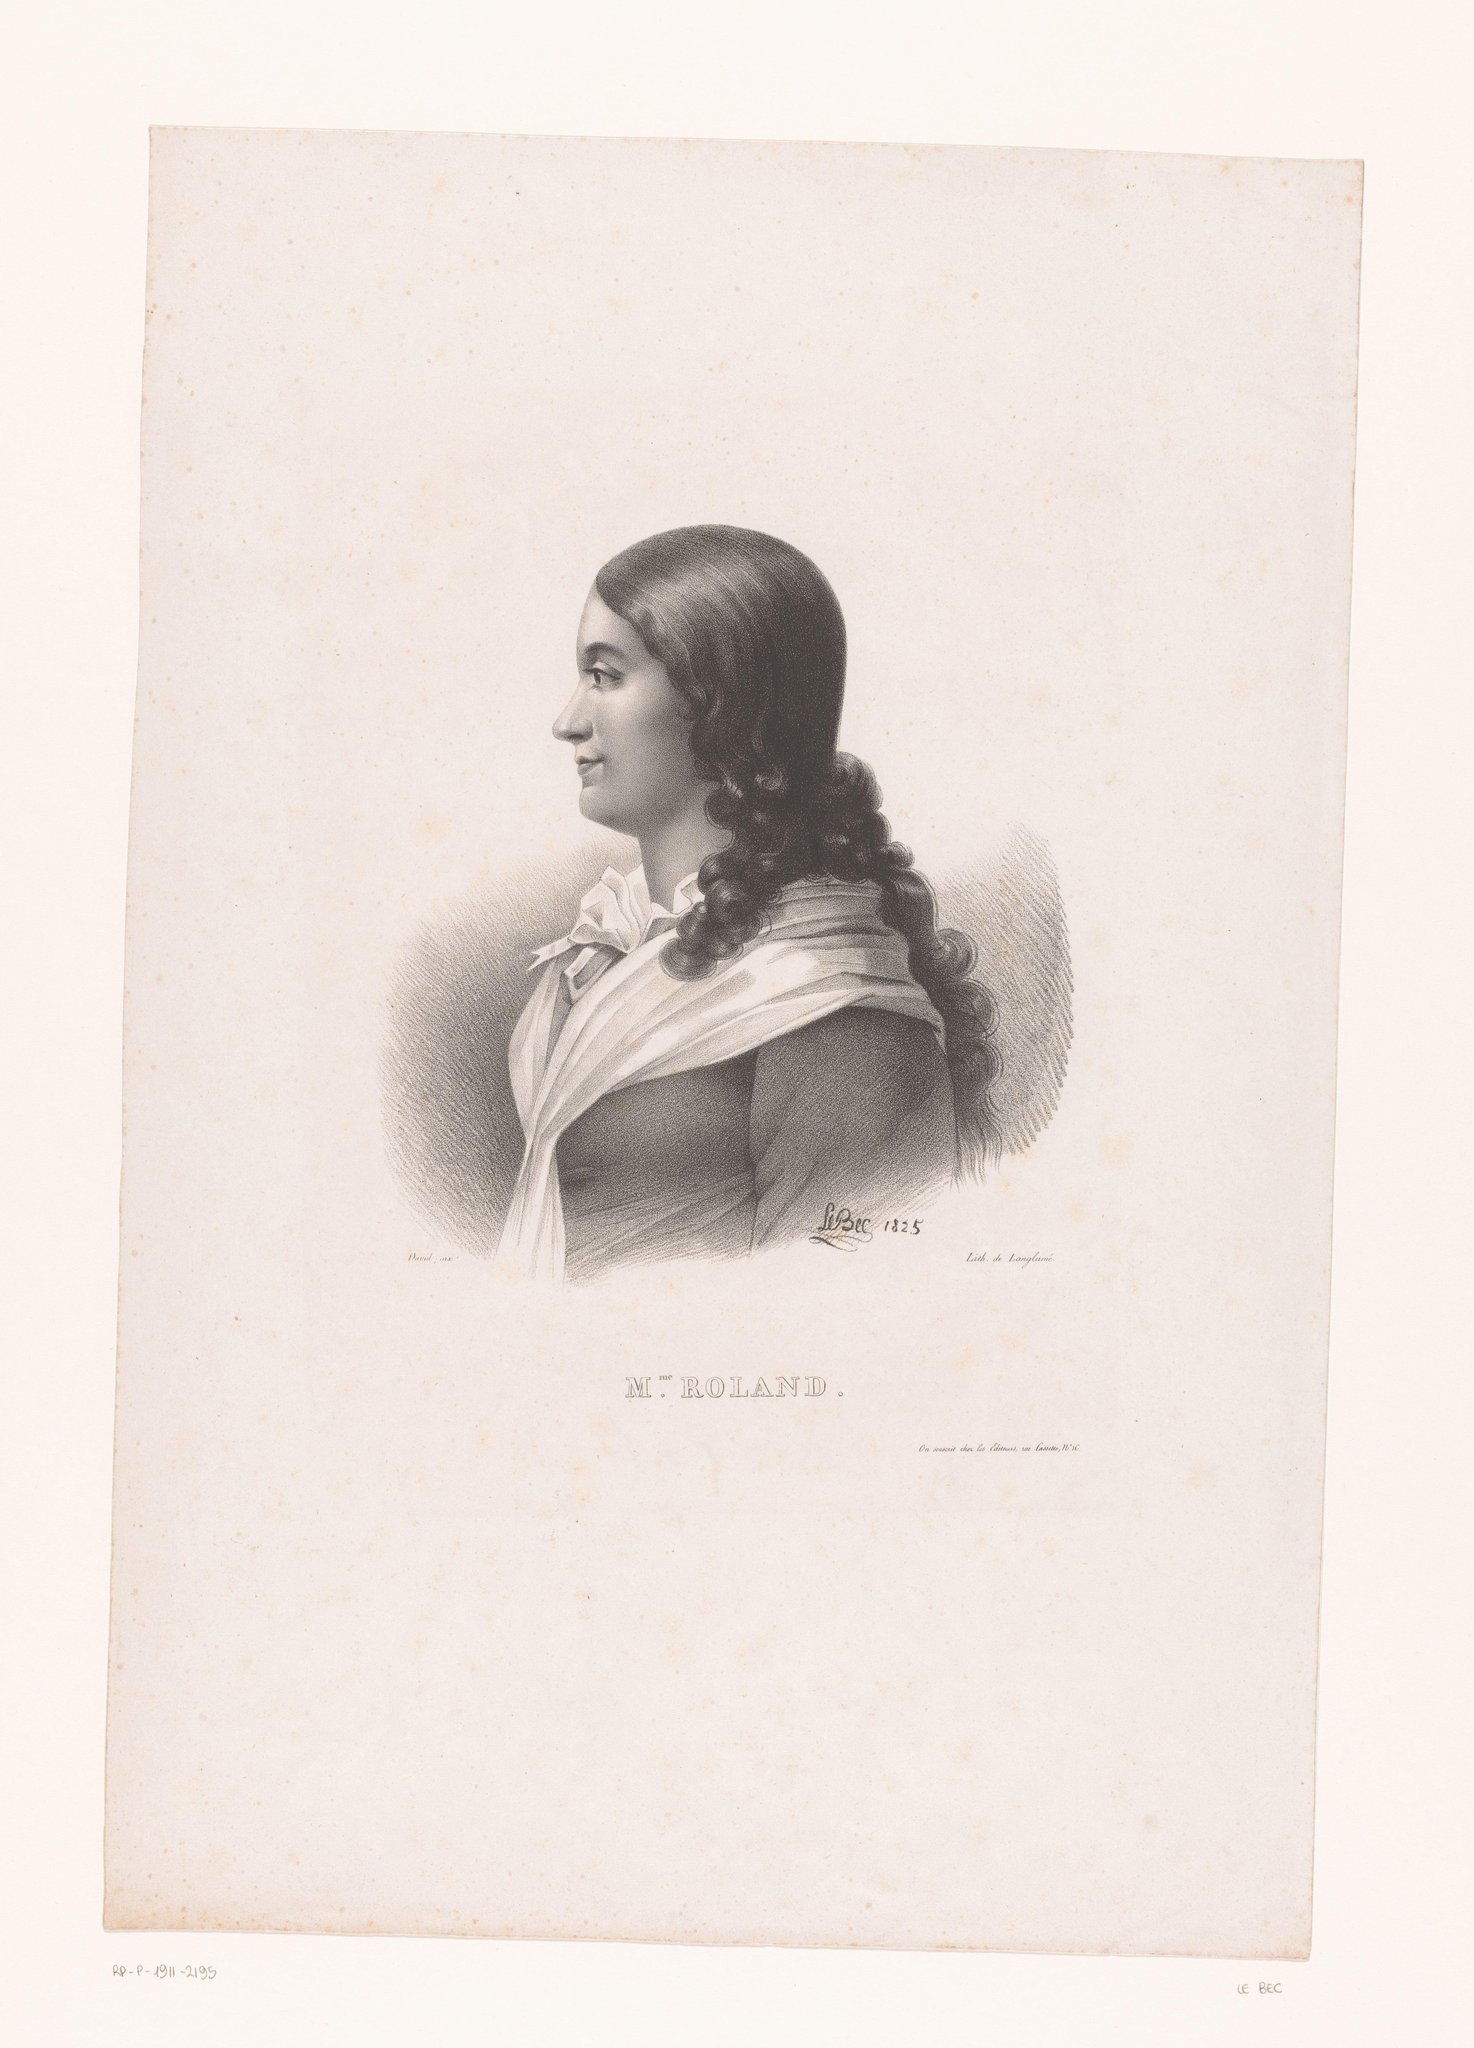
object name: print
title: Mme. Roland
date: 1825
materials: paper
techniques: lithograph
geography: paris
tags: historical persons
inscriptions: collector's mark: Lugt 2228a